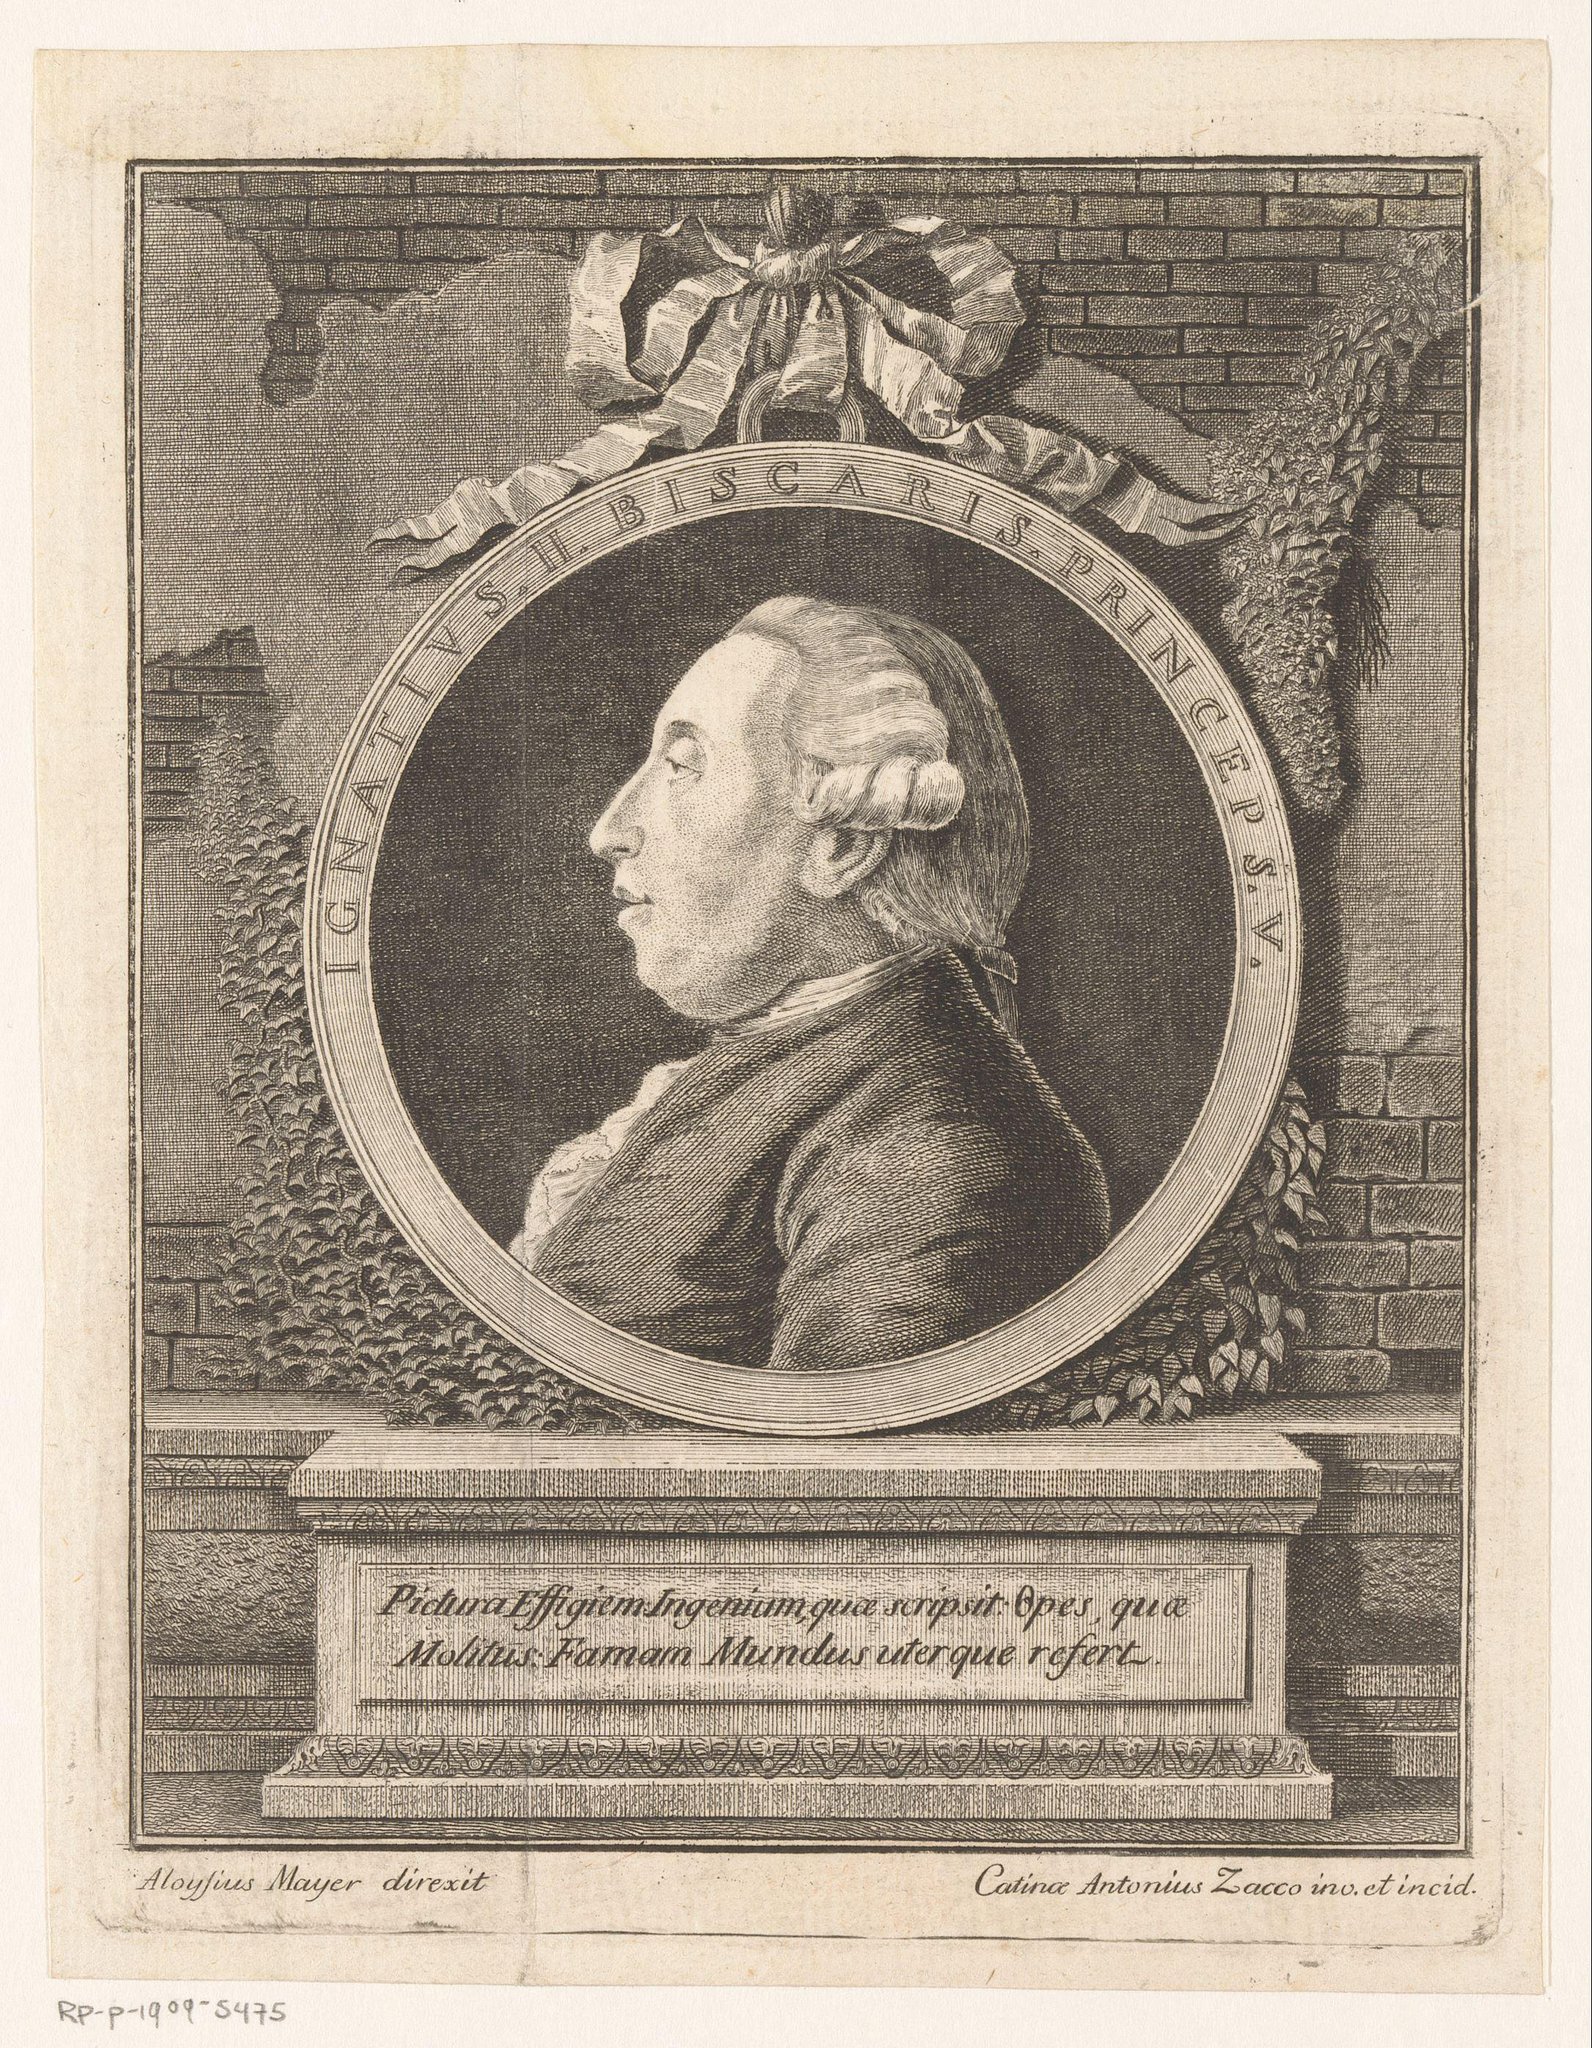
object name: print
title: Portret van Ignazio Paternò Castello, prins van Biscari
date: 1757-1831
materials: paper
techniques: etching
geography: italy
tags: historical persons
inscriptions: collector's mark: Lugt 2228